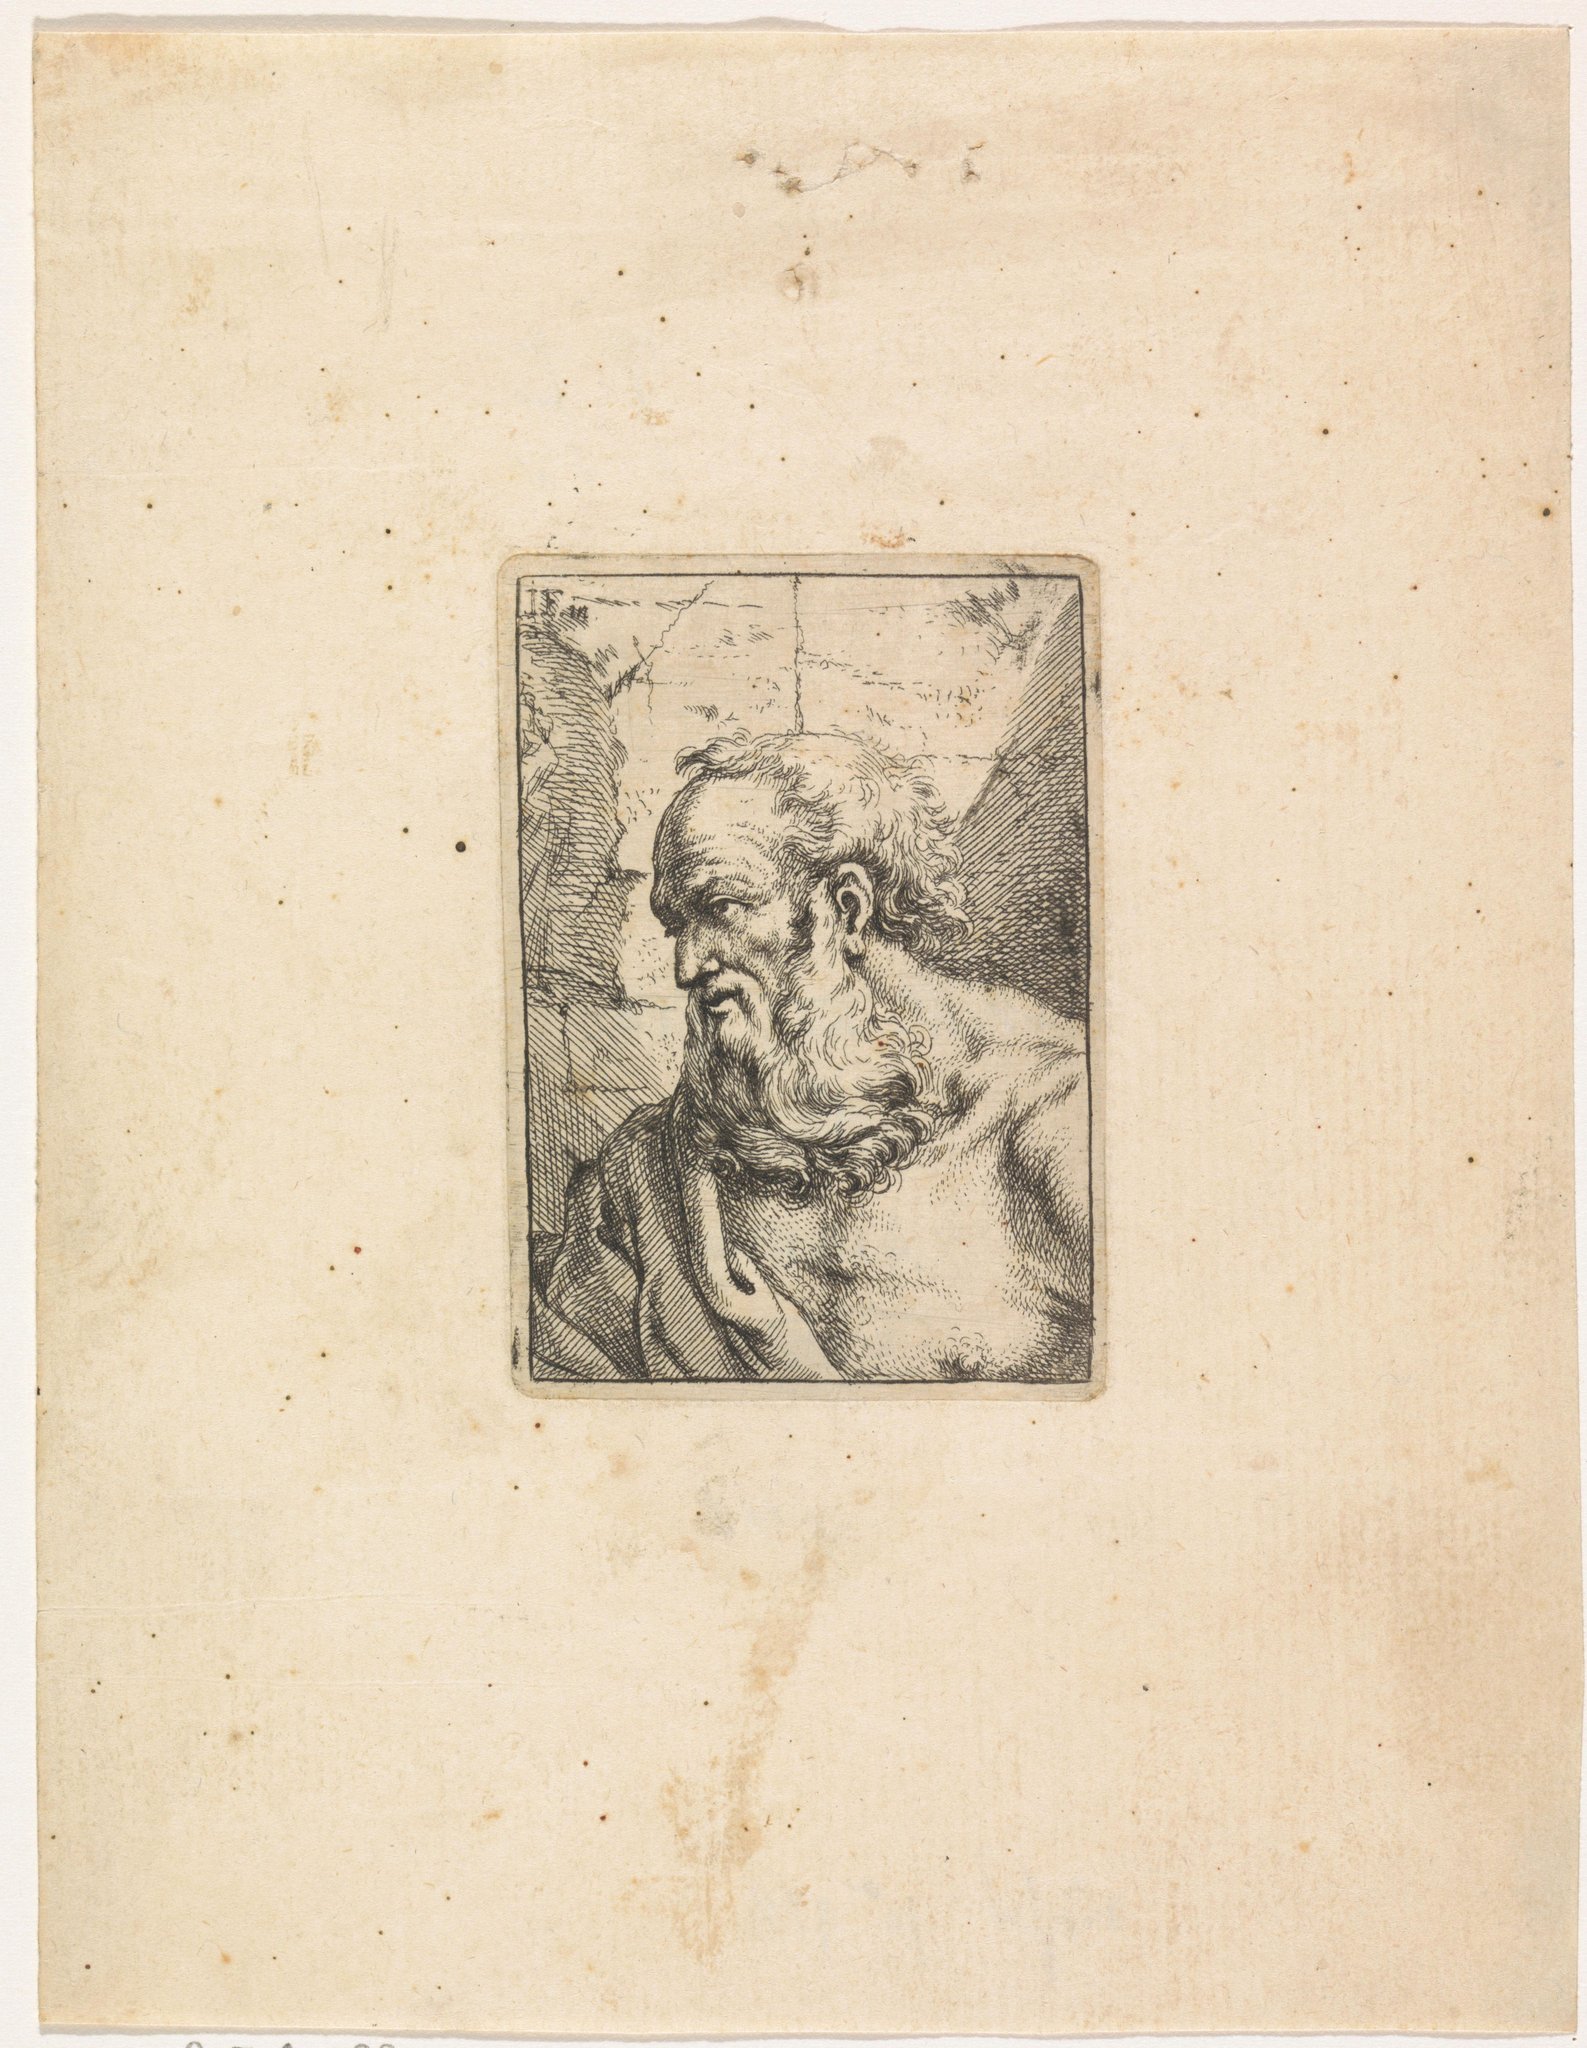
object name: print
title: Buste van een oude man met baard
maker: monogrammist if (graveur)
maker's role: print maker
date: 1650-1700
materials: paper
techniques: etching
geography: netherlands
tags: chest, bust, beard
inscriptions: collector's mark: Lugt 2228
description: Buste van een oude man met baard in profiel naar links. Over een schouder een toga.